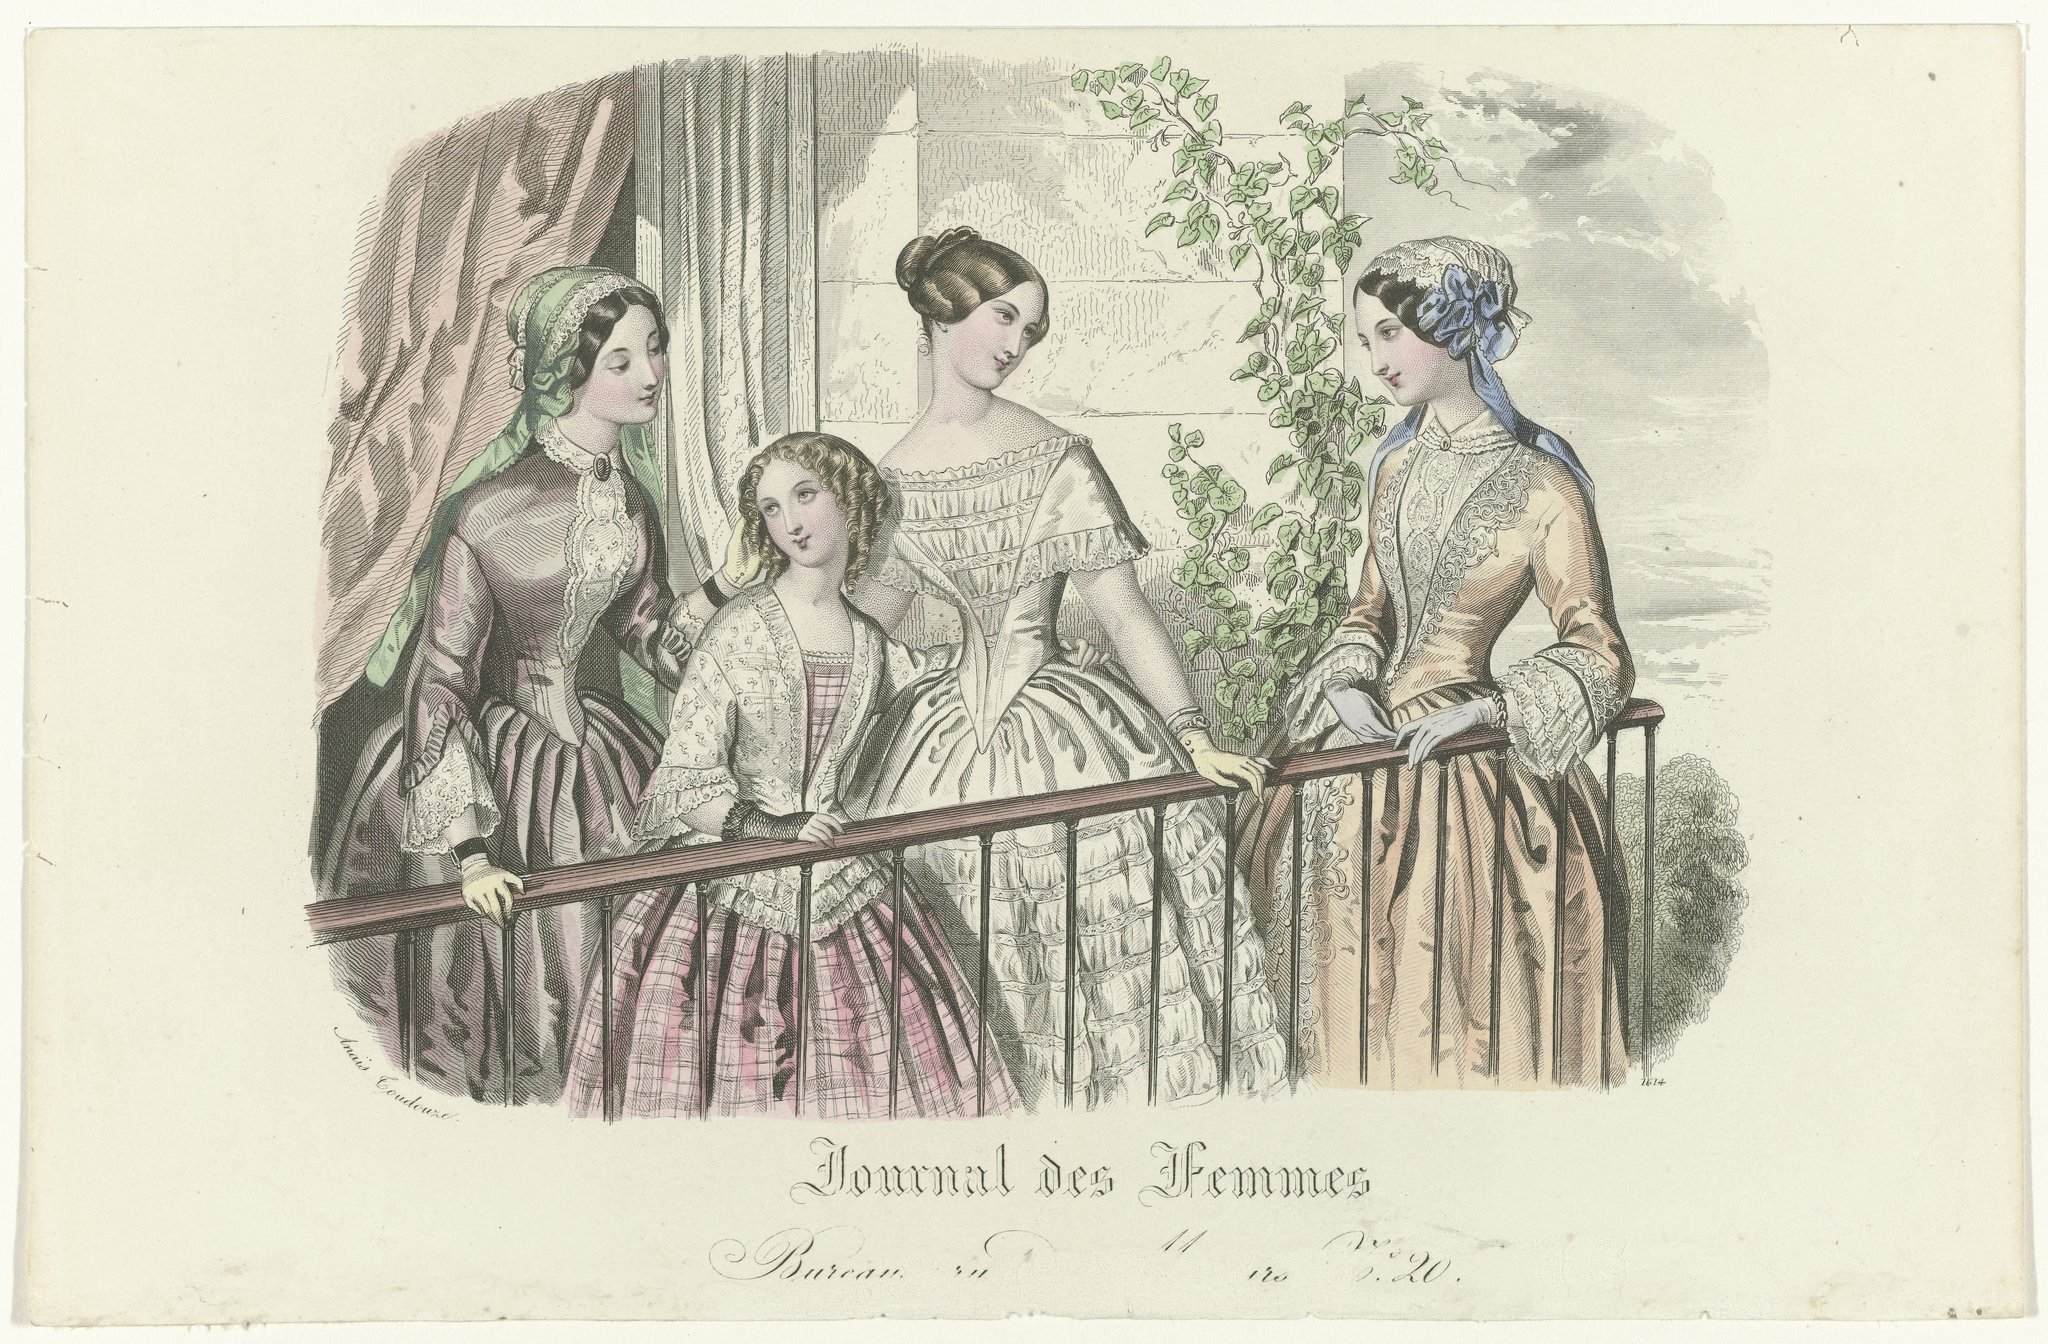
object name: fashion print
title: Journal des Femmes, ca. 1850, No. 1614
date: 1850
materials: paper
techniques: engraving, hand coloring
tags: gloves, mittens (short gloves) (+ women's clothes), gloves, mittens (mitaines) (+ women's clothes), clothing for the upper part of the body: blouse (+ girls' clothes), head-gear: cap (+ women's clothes), fashion plates, balustrade, balcony, bracelet, wristlet (+ women's clothes), dress, gown (+ girls' clothes)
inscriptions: title: ‘Journal des Femmes’, address: ‘Bureaux rue des Martyrs, No. 20.’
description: Drie vrouwen en een meisje staan op een balkon bij een balustrade. Prent uit het modetijdschrift Journal des Femmes (1840-1851).